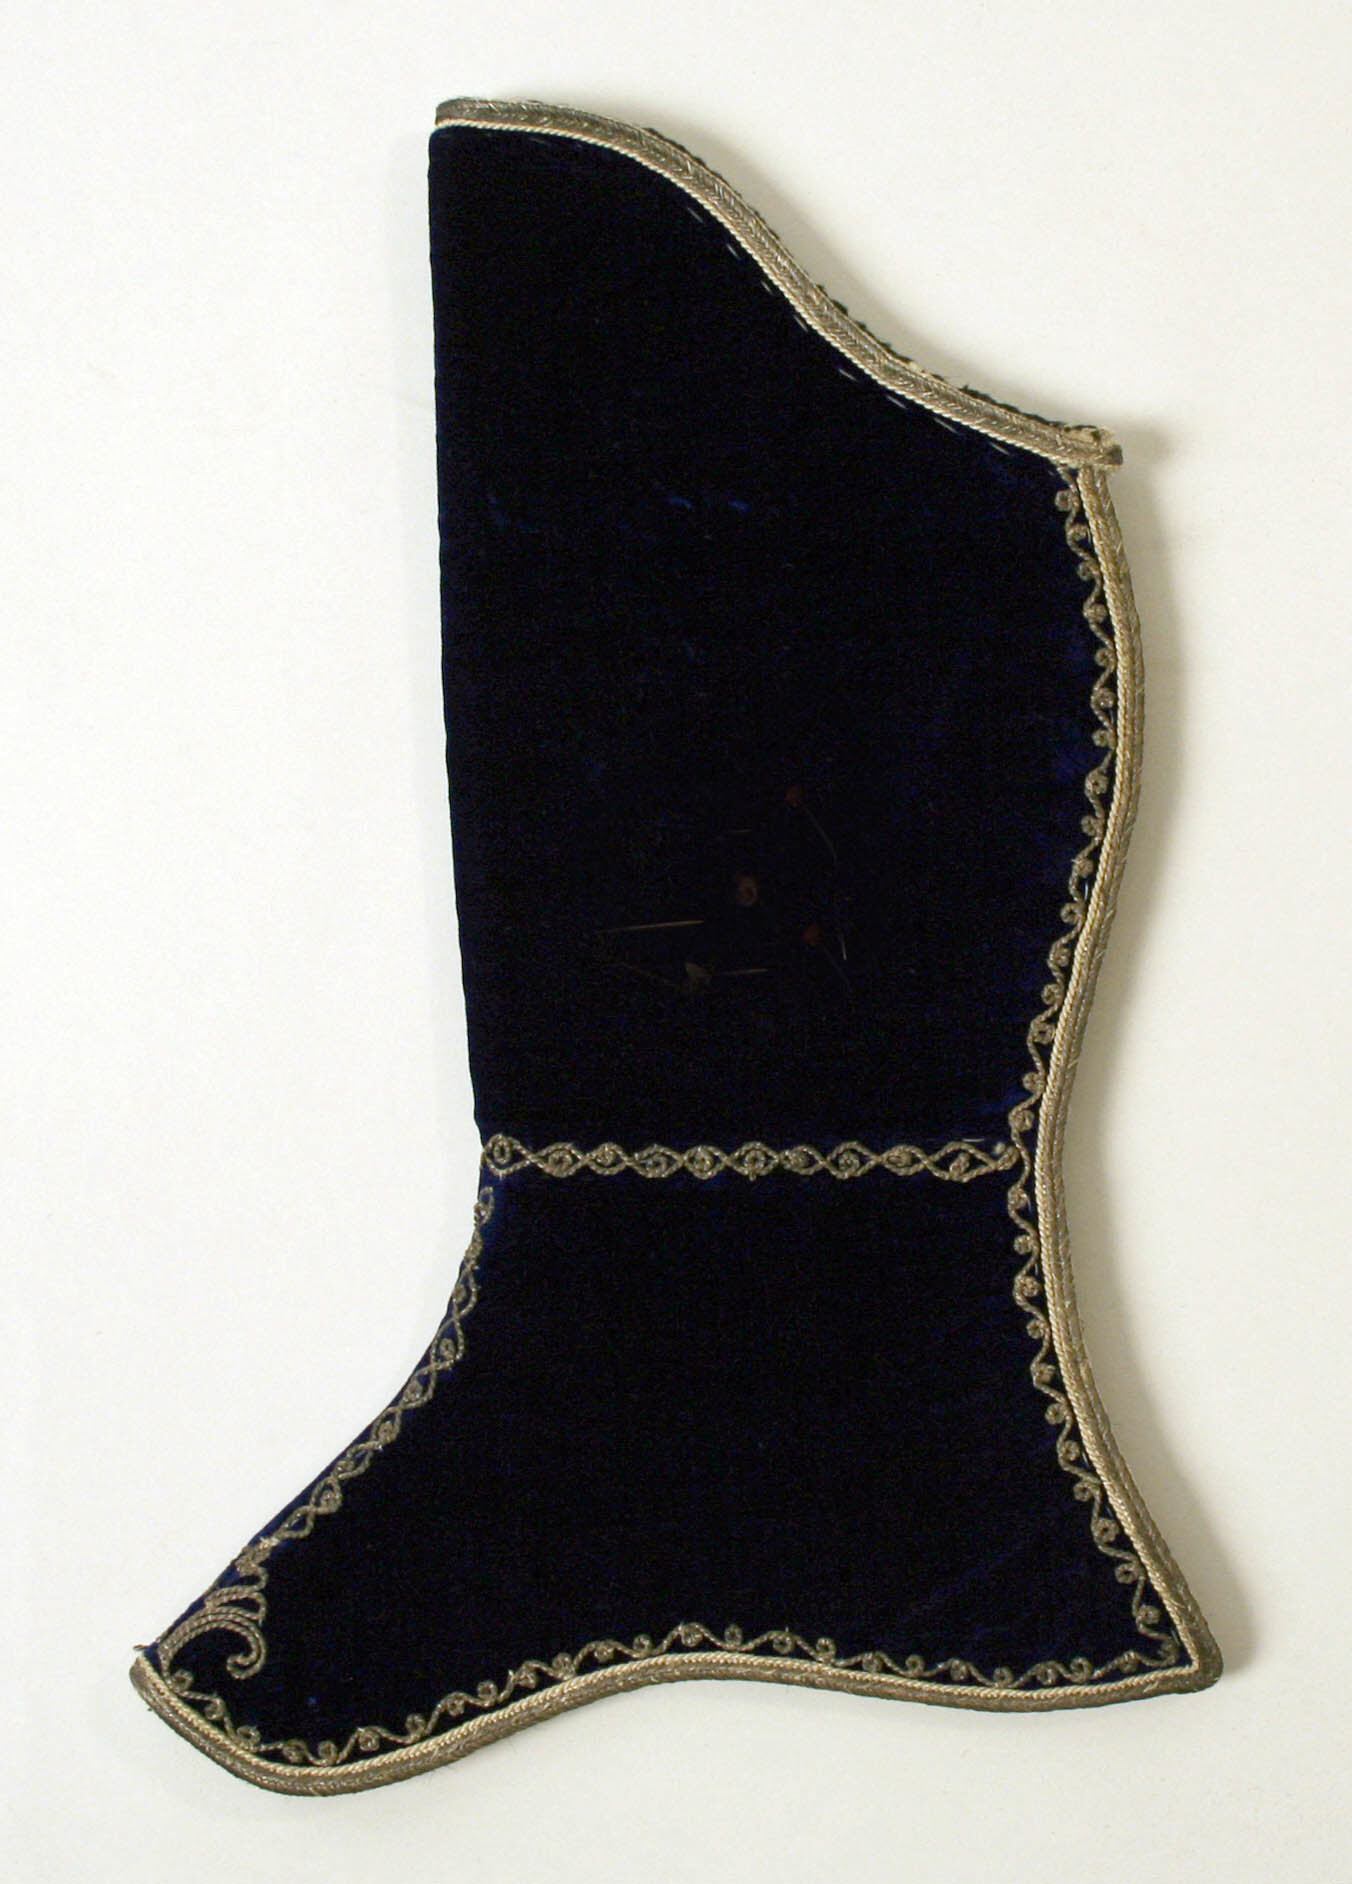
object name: gaiter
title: Gaiters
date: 1882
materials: metal, silk, wool